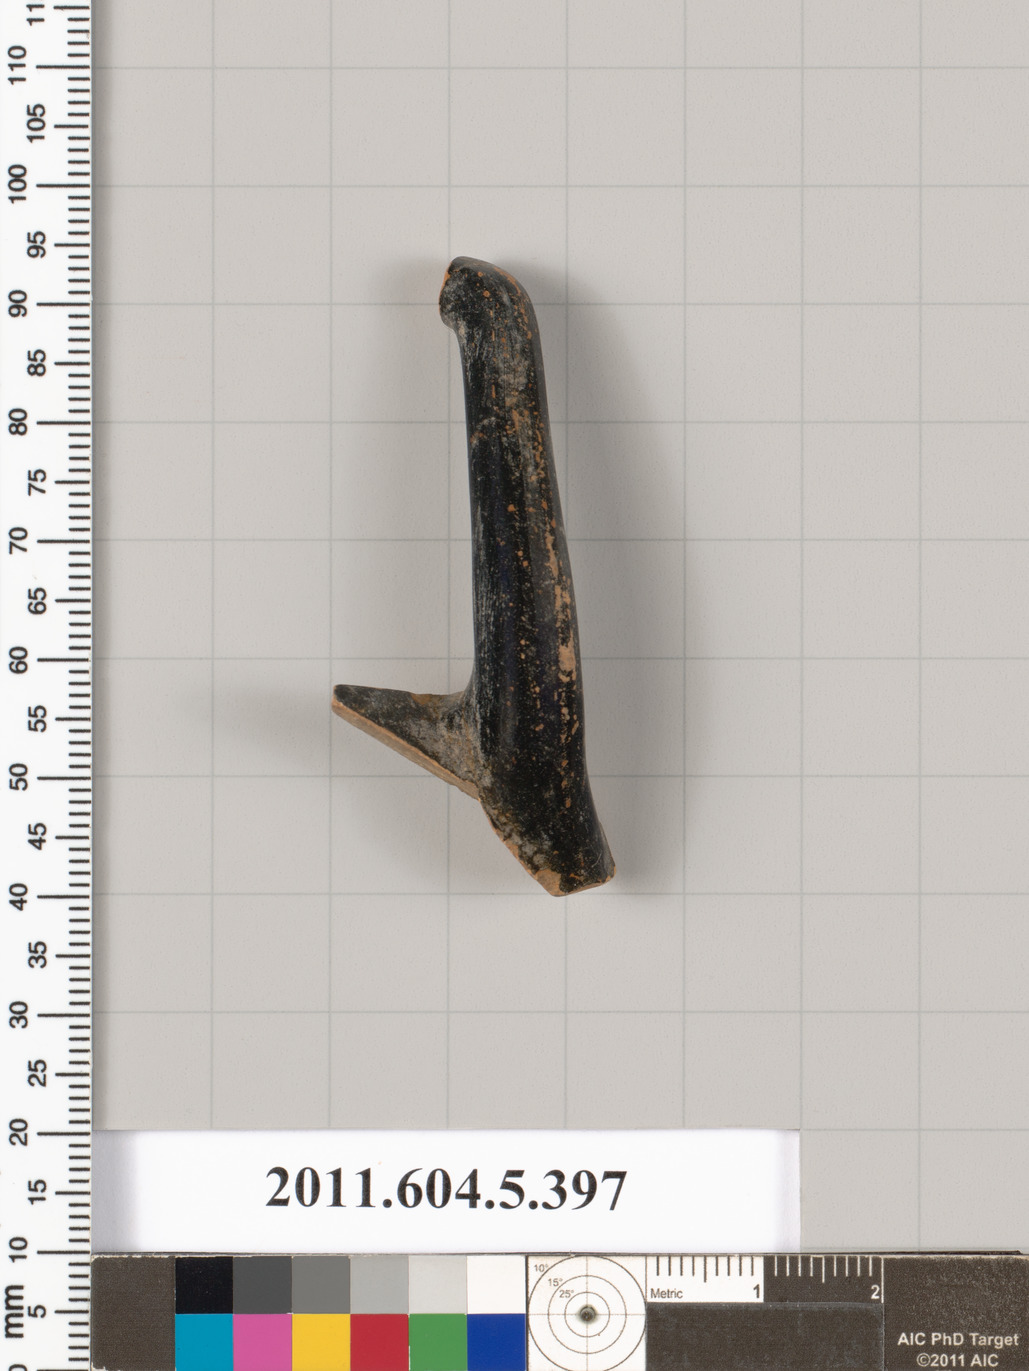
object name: kylix fragment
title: Terracotta fragment of a kylix (drinking cup)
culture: greek, attic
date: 600-401 BCE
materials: terracotta